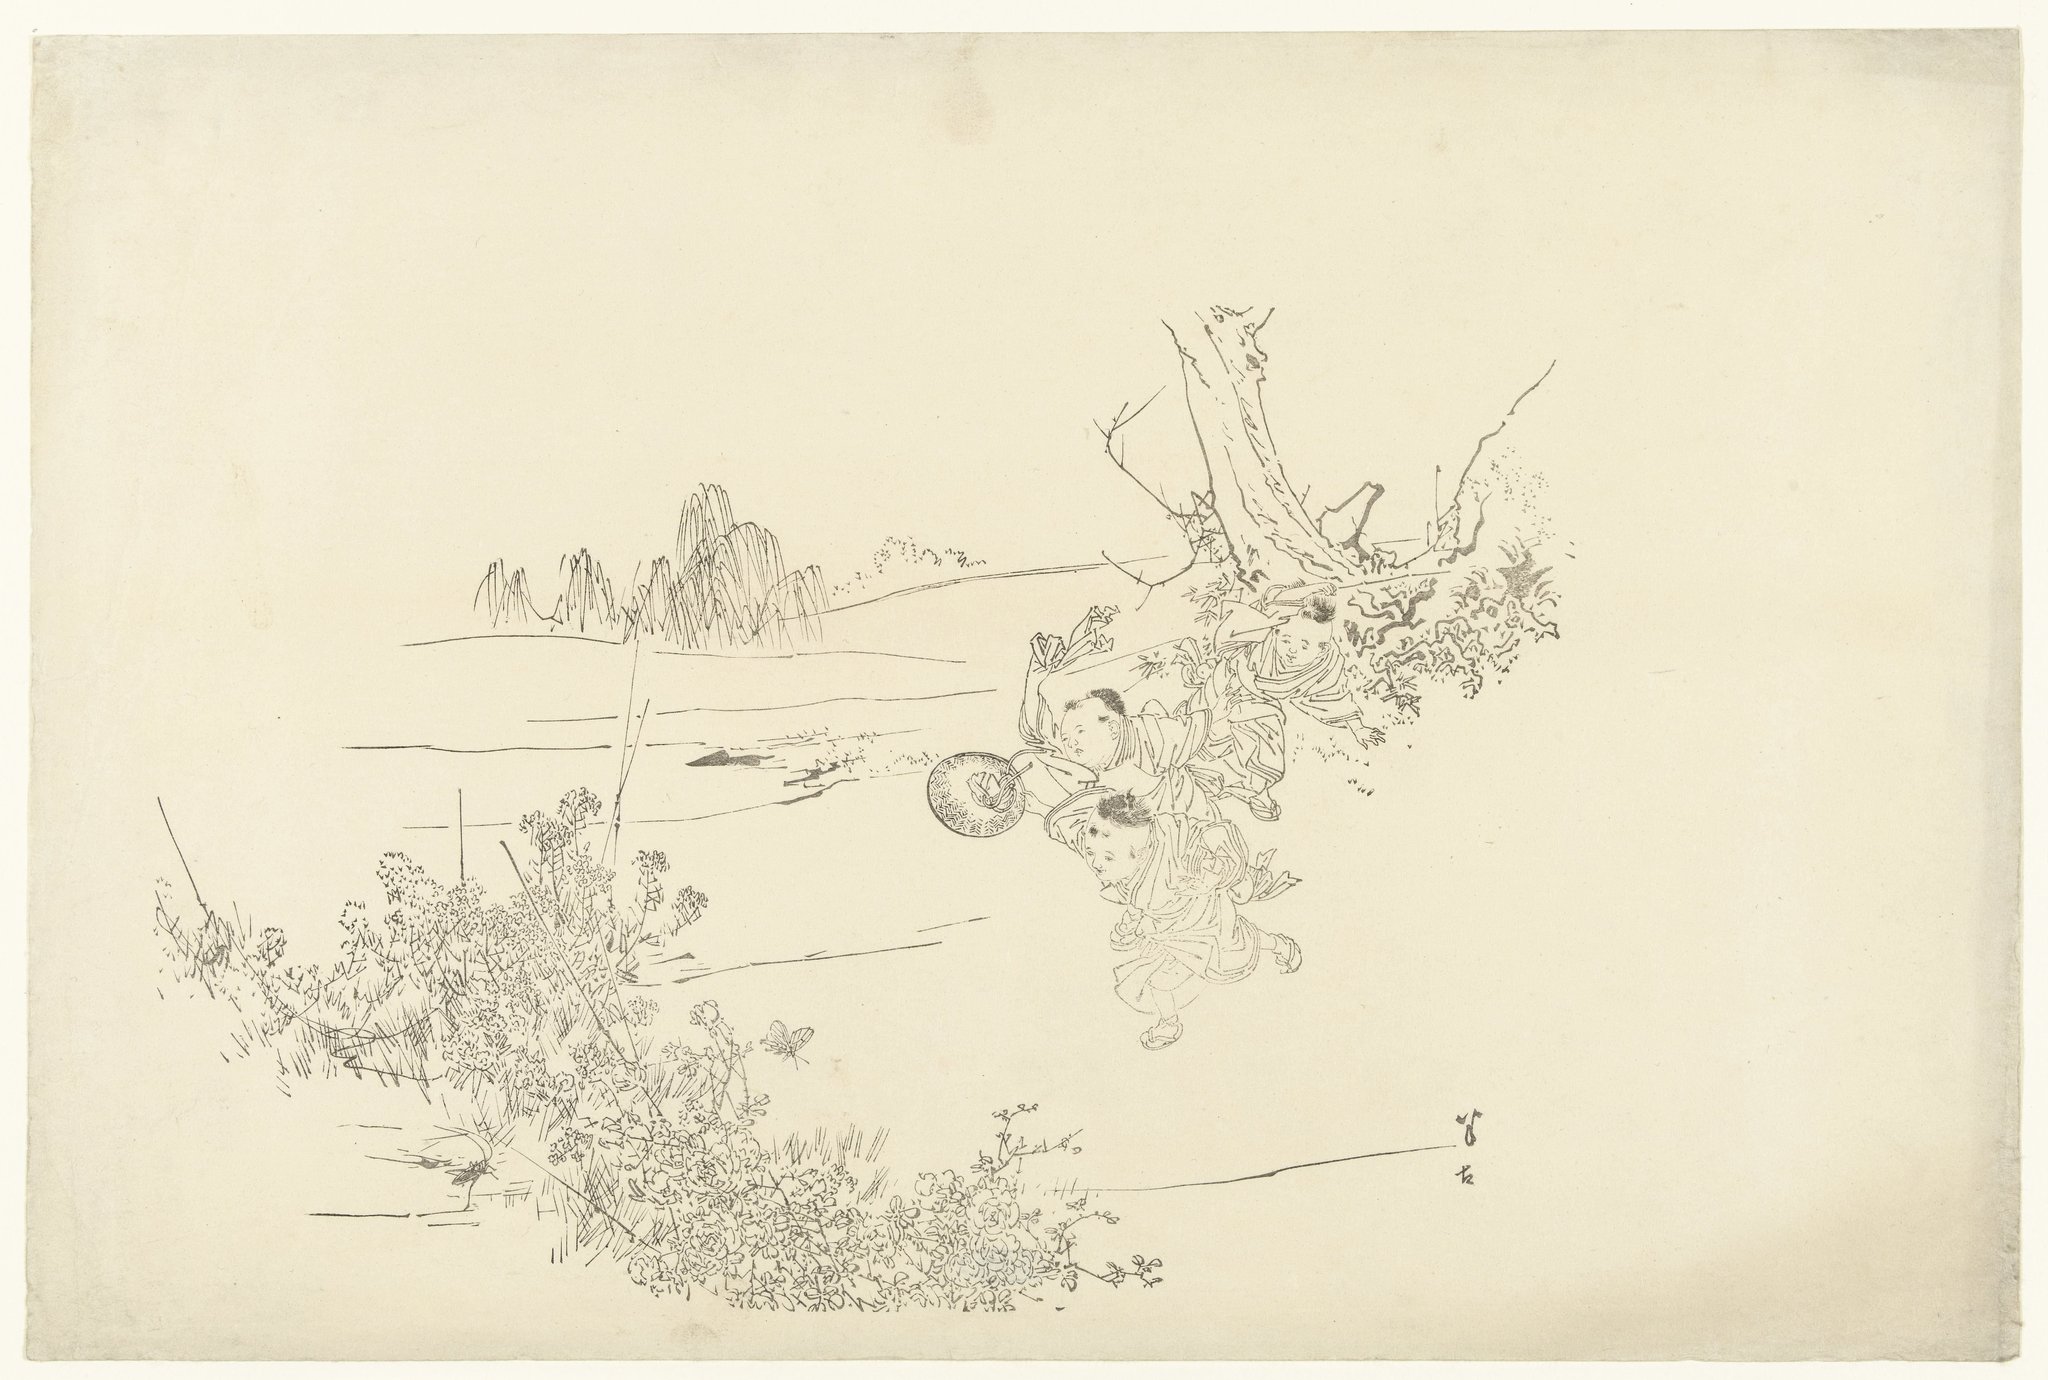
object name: print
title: Vlinders vangen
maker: kajita hanko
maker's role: print maker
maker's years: 1870-1917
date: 1890-1900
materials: paper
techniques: woodcut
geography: japan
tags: catching animals, landscapes (+ landscape with figures, staffage)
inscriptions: collector's mark: Lugt 2228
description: Drie kinderen op een rivieroever, rennend in de richting van een vlinder bij struikgewas. Afdruk van het lijnblok.